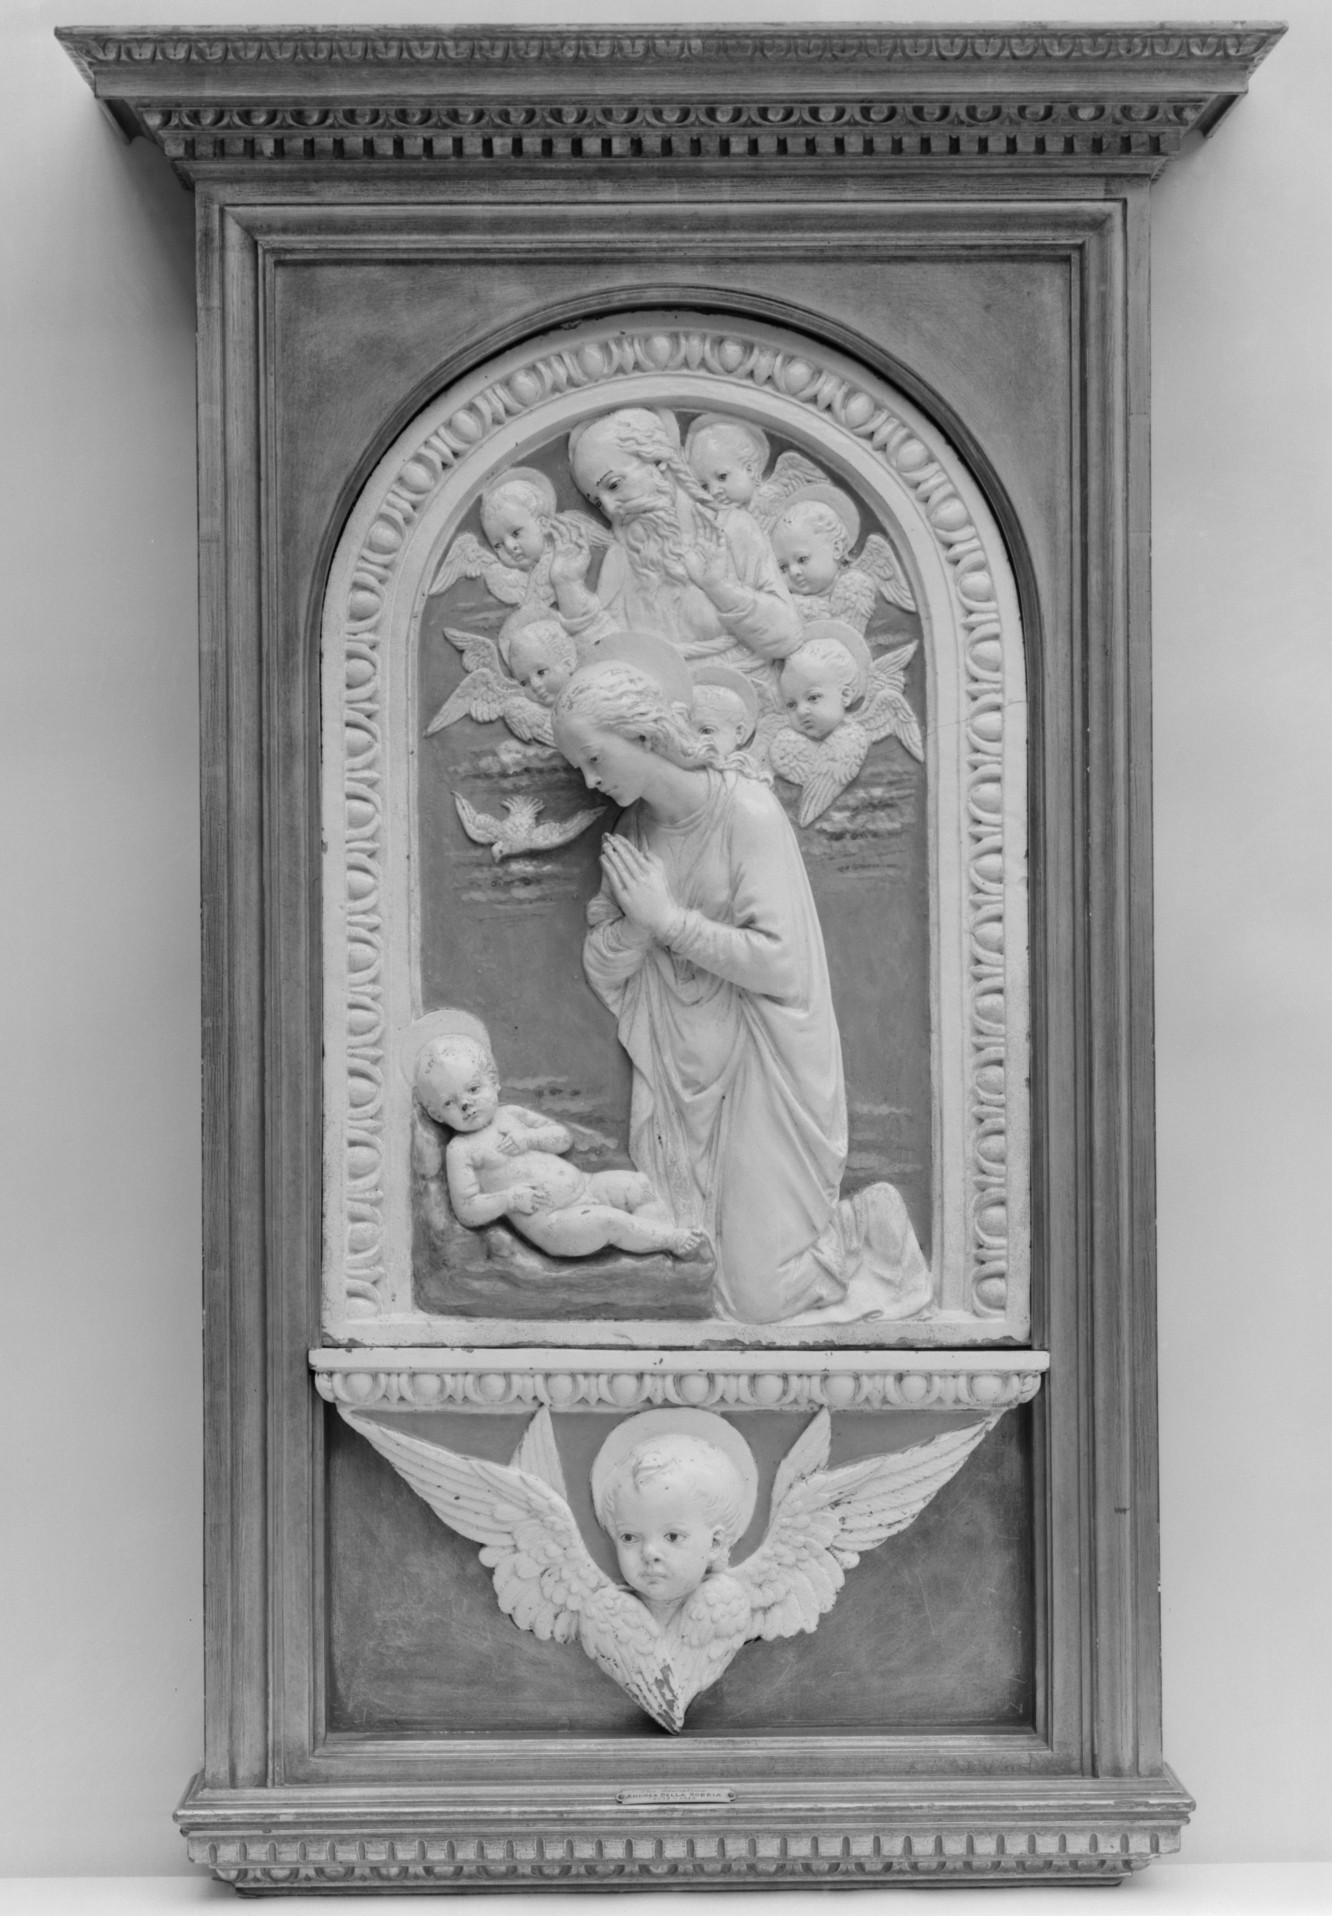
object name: ba relief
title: Virgin Adoring the Christ Child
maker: andrea della robbia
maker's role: artist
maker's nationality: italian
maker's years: 1435-1525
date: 1479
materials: gilt, terracotta, wood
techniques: glazing, relief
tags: birds,men,cupid,virgin mary,jesus